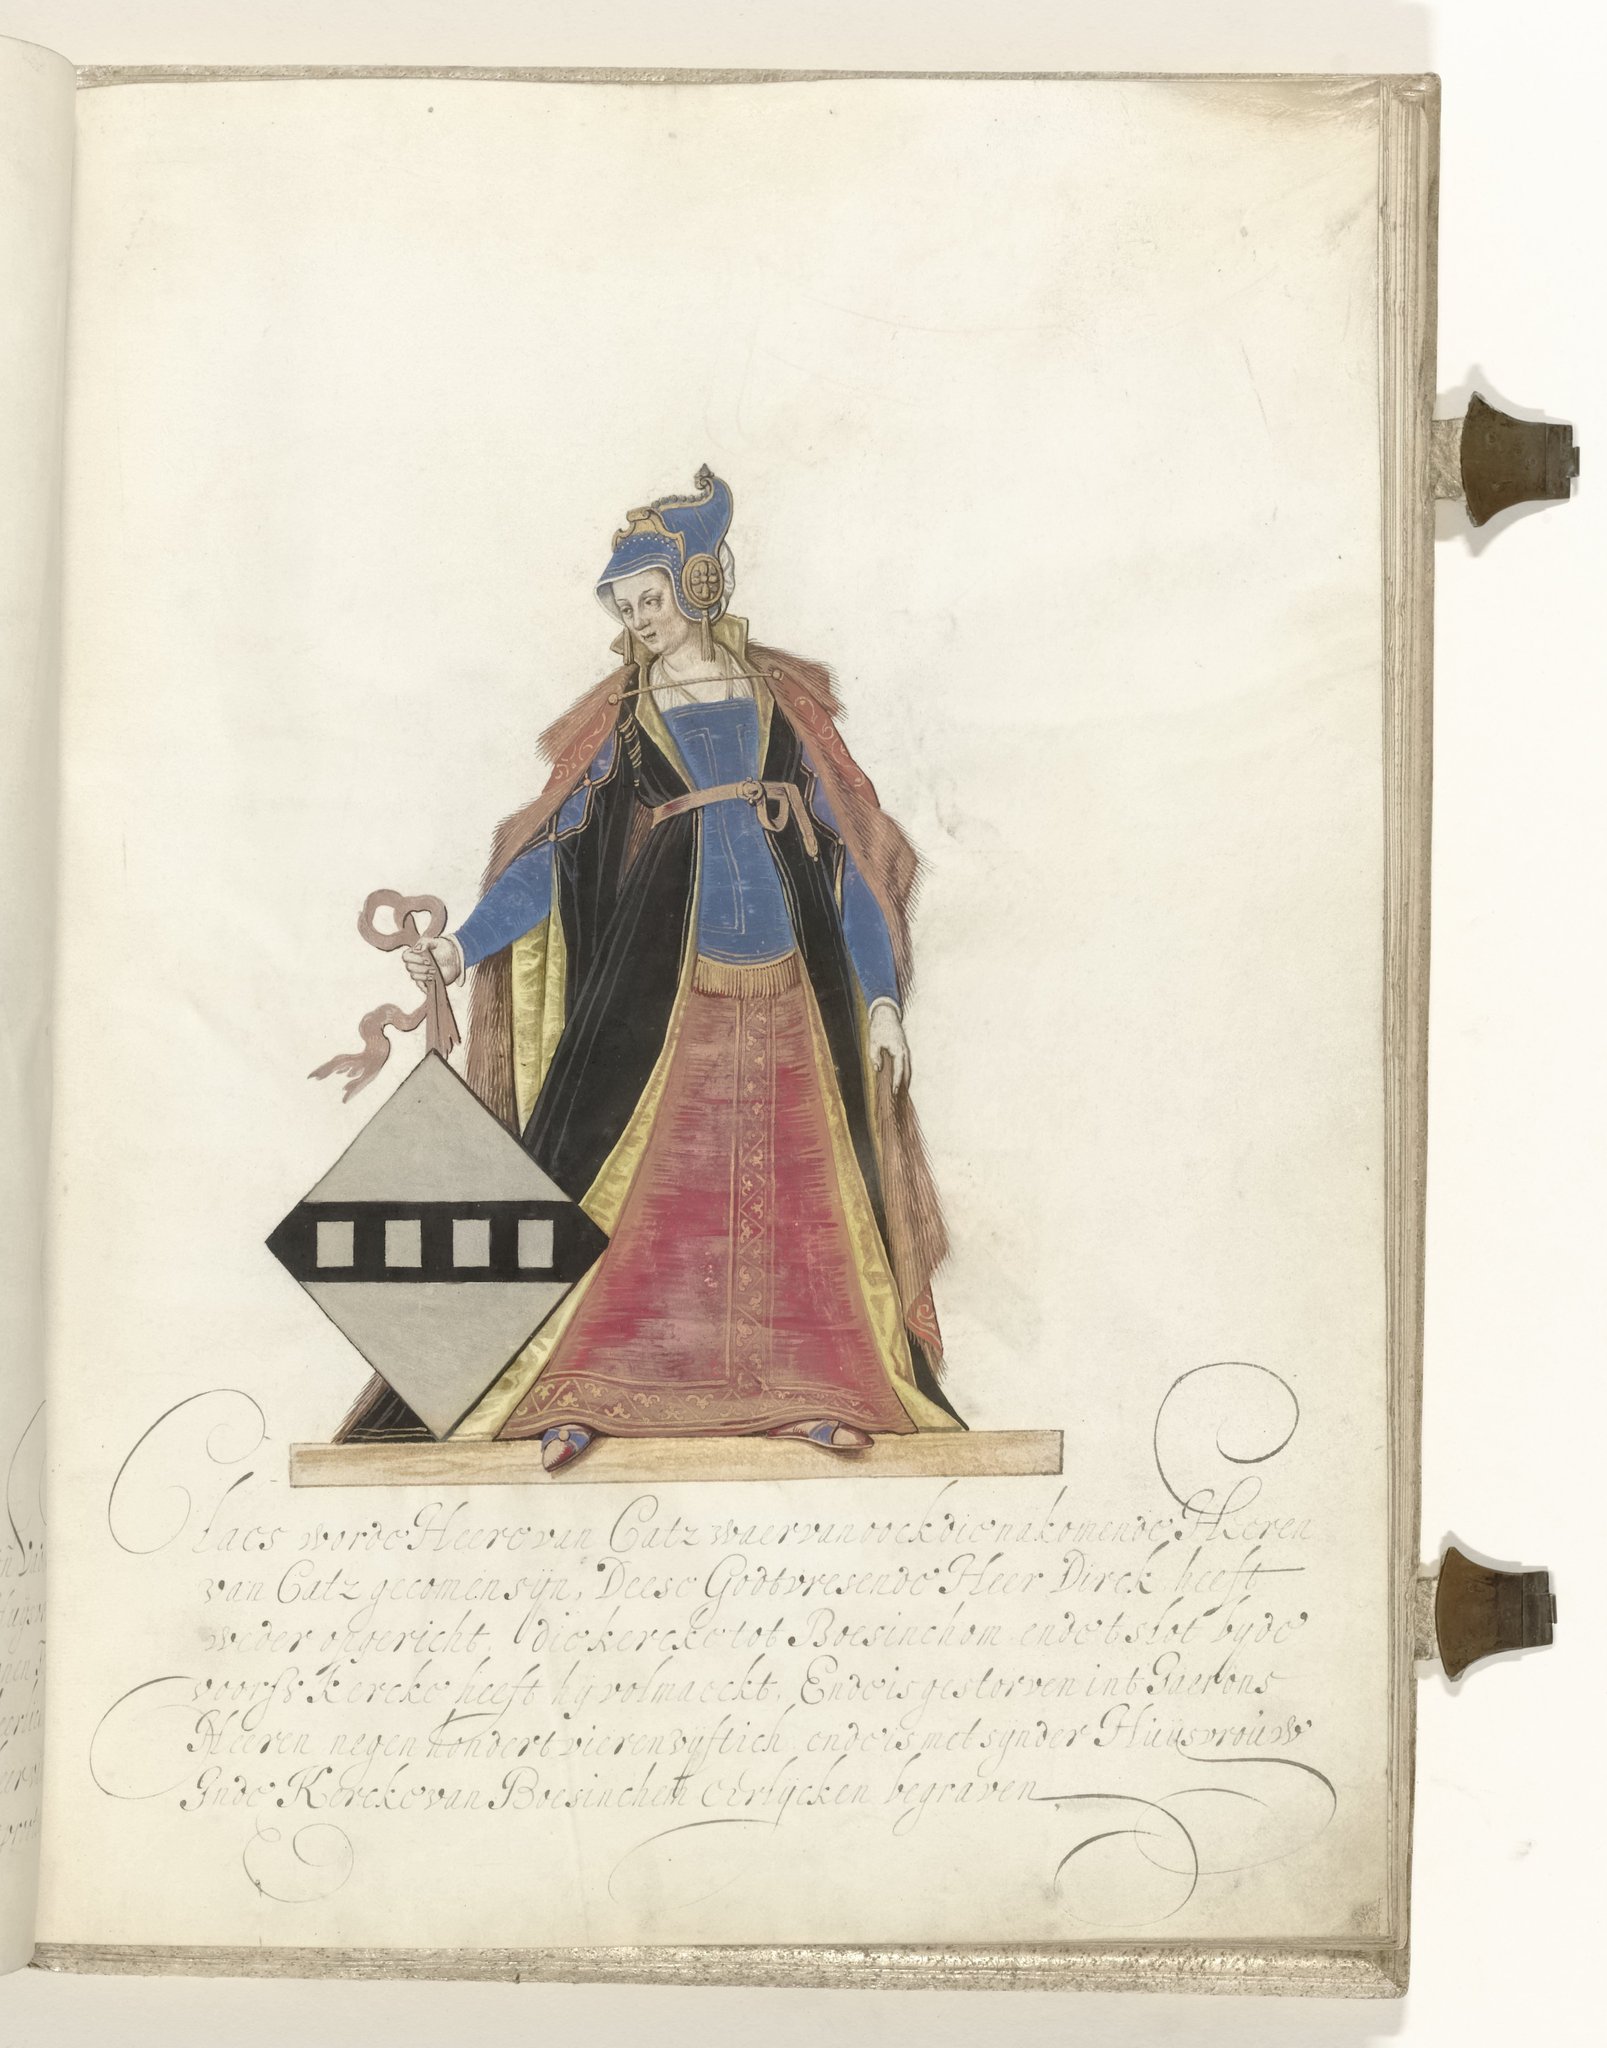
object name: drawing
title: Gravin van Beusichem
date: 1590-1593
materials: paint, gouache, ink, parchment, watercolor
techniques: writing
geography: northern netherlands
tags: culemborg, heren en graven van, heren van beusichem, culemborg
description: Gravin van Beusichem, echtgenote van Dirk, graaf van Beusichem (Boesinchem). Zij was de dochter van de heer van Spijck. Staande ten voeten uit, in haar rechterhand een wapen. Onderdeel van geïllustreerd handschrift met de genealogie van de heren en graven van Culemborg.